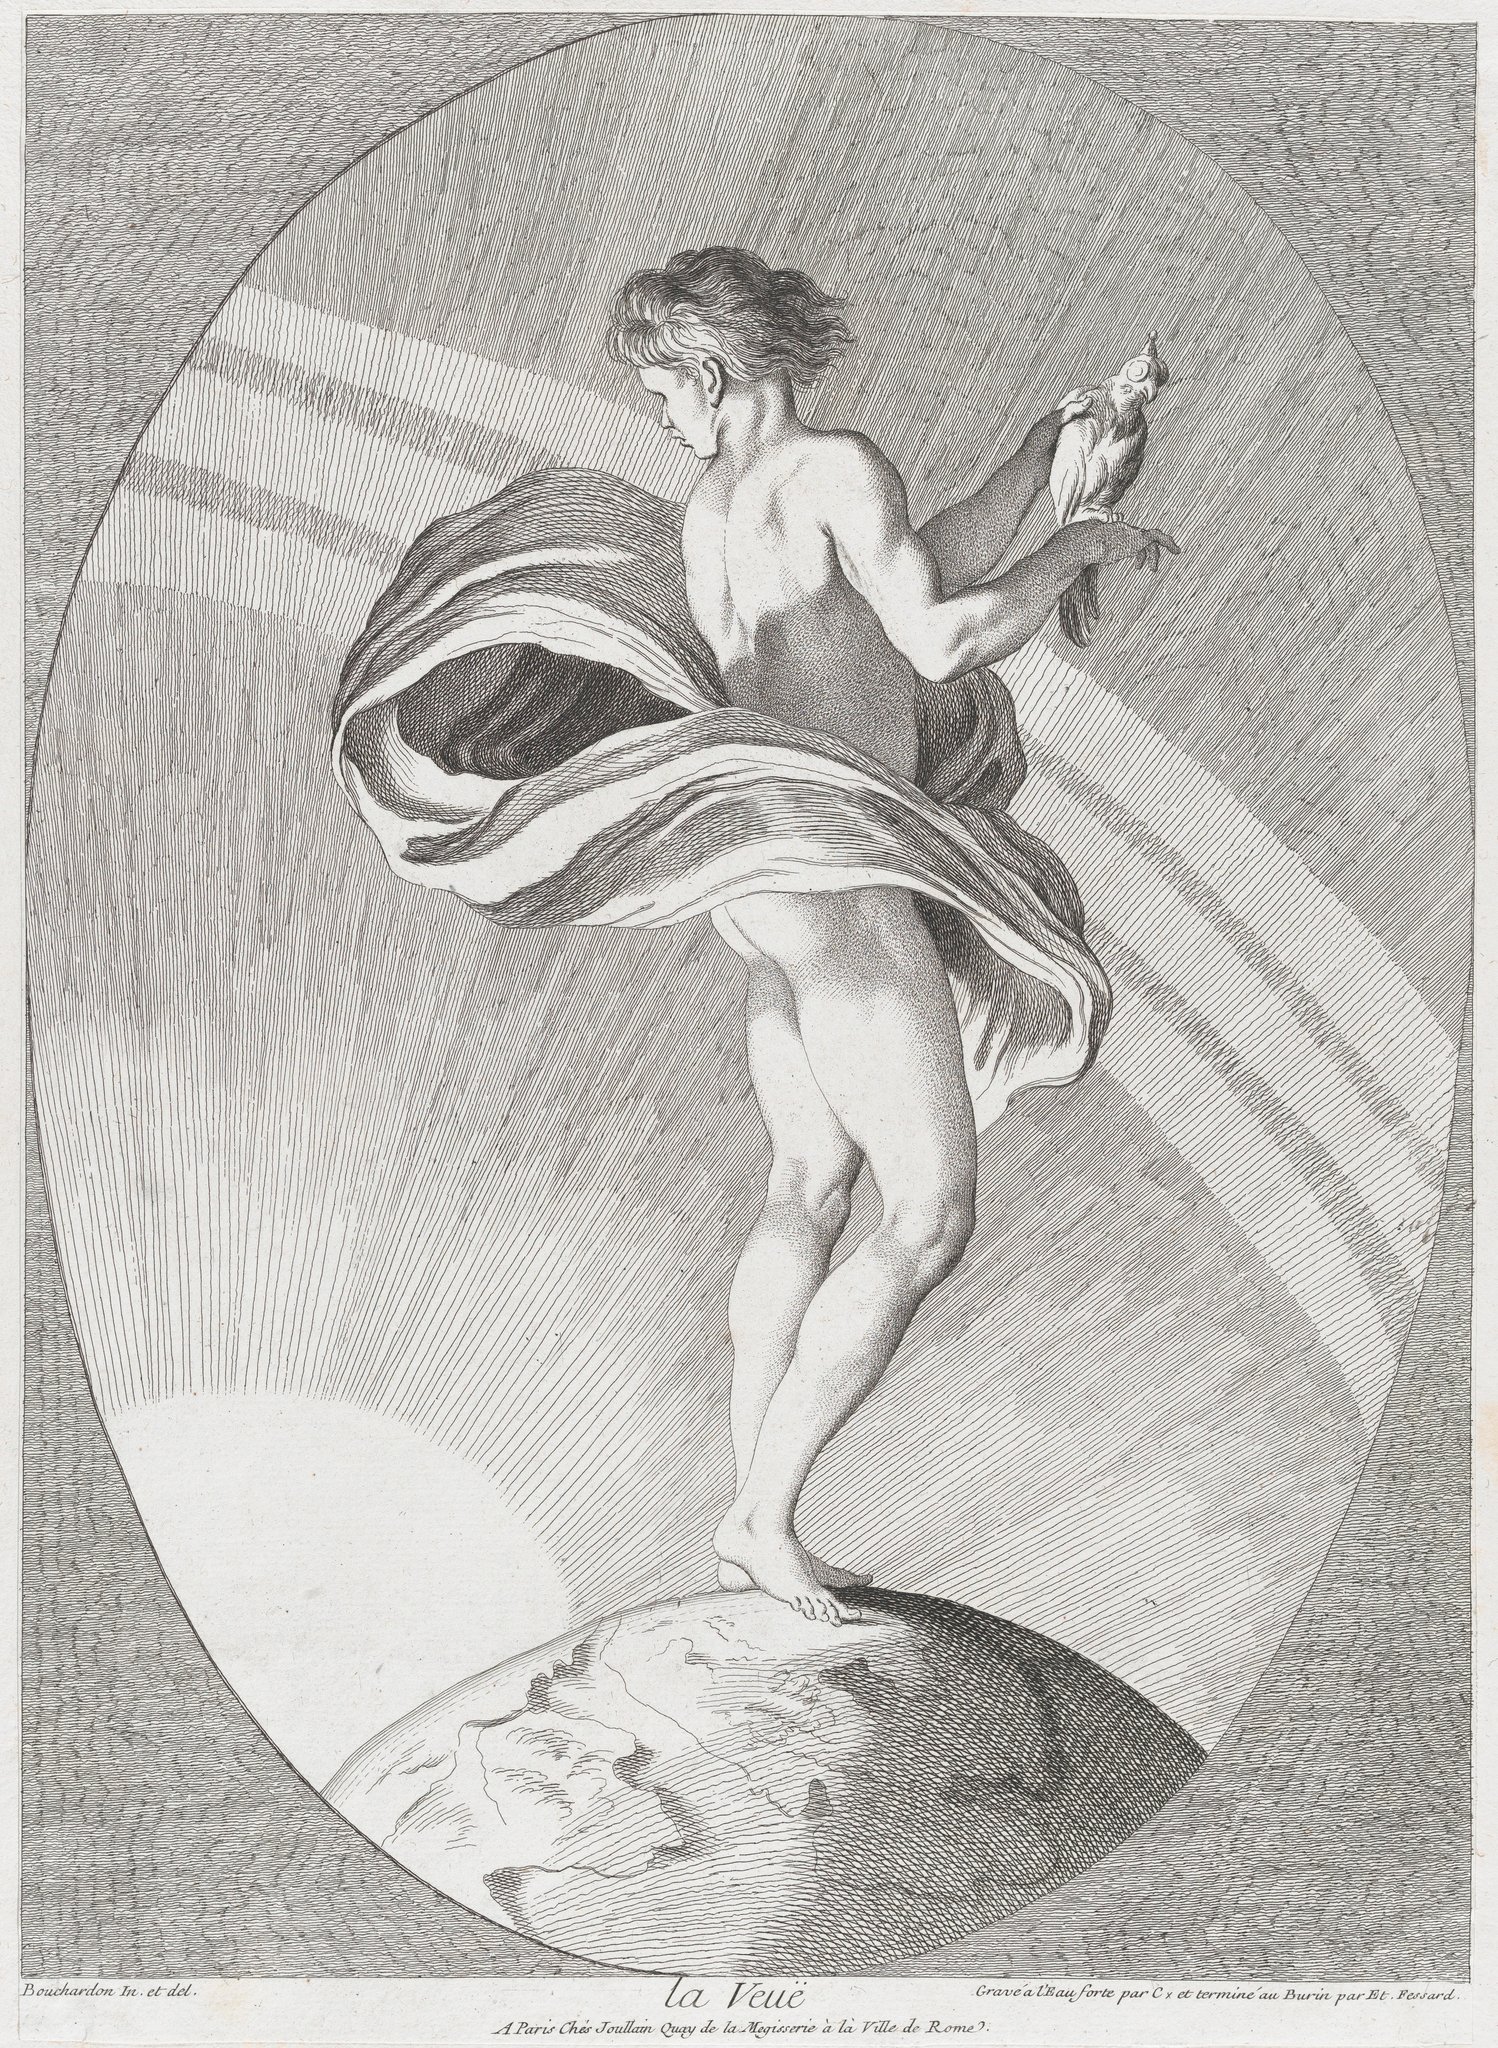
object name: print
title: Sight, from "The Five Senses"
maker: anne claude philippe de tubières, comte de caylus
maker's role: artist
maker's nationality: french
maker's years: 1692-1765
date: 1730-1765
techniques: engraving, etching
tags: female nudes